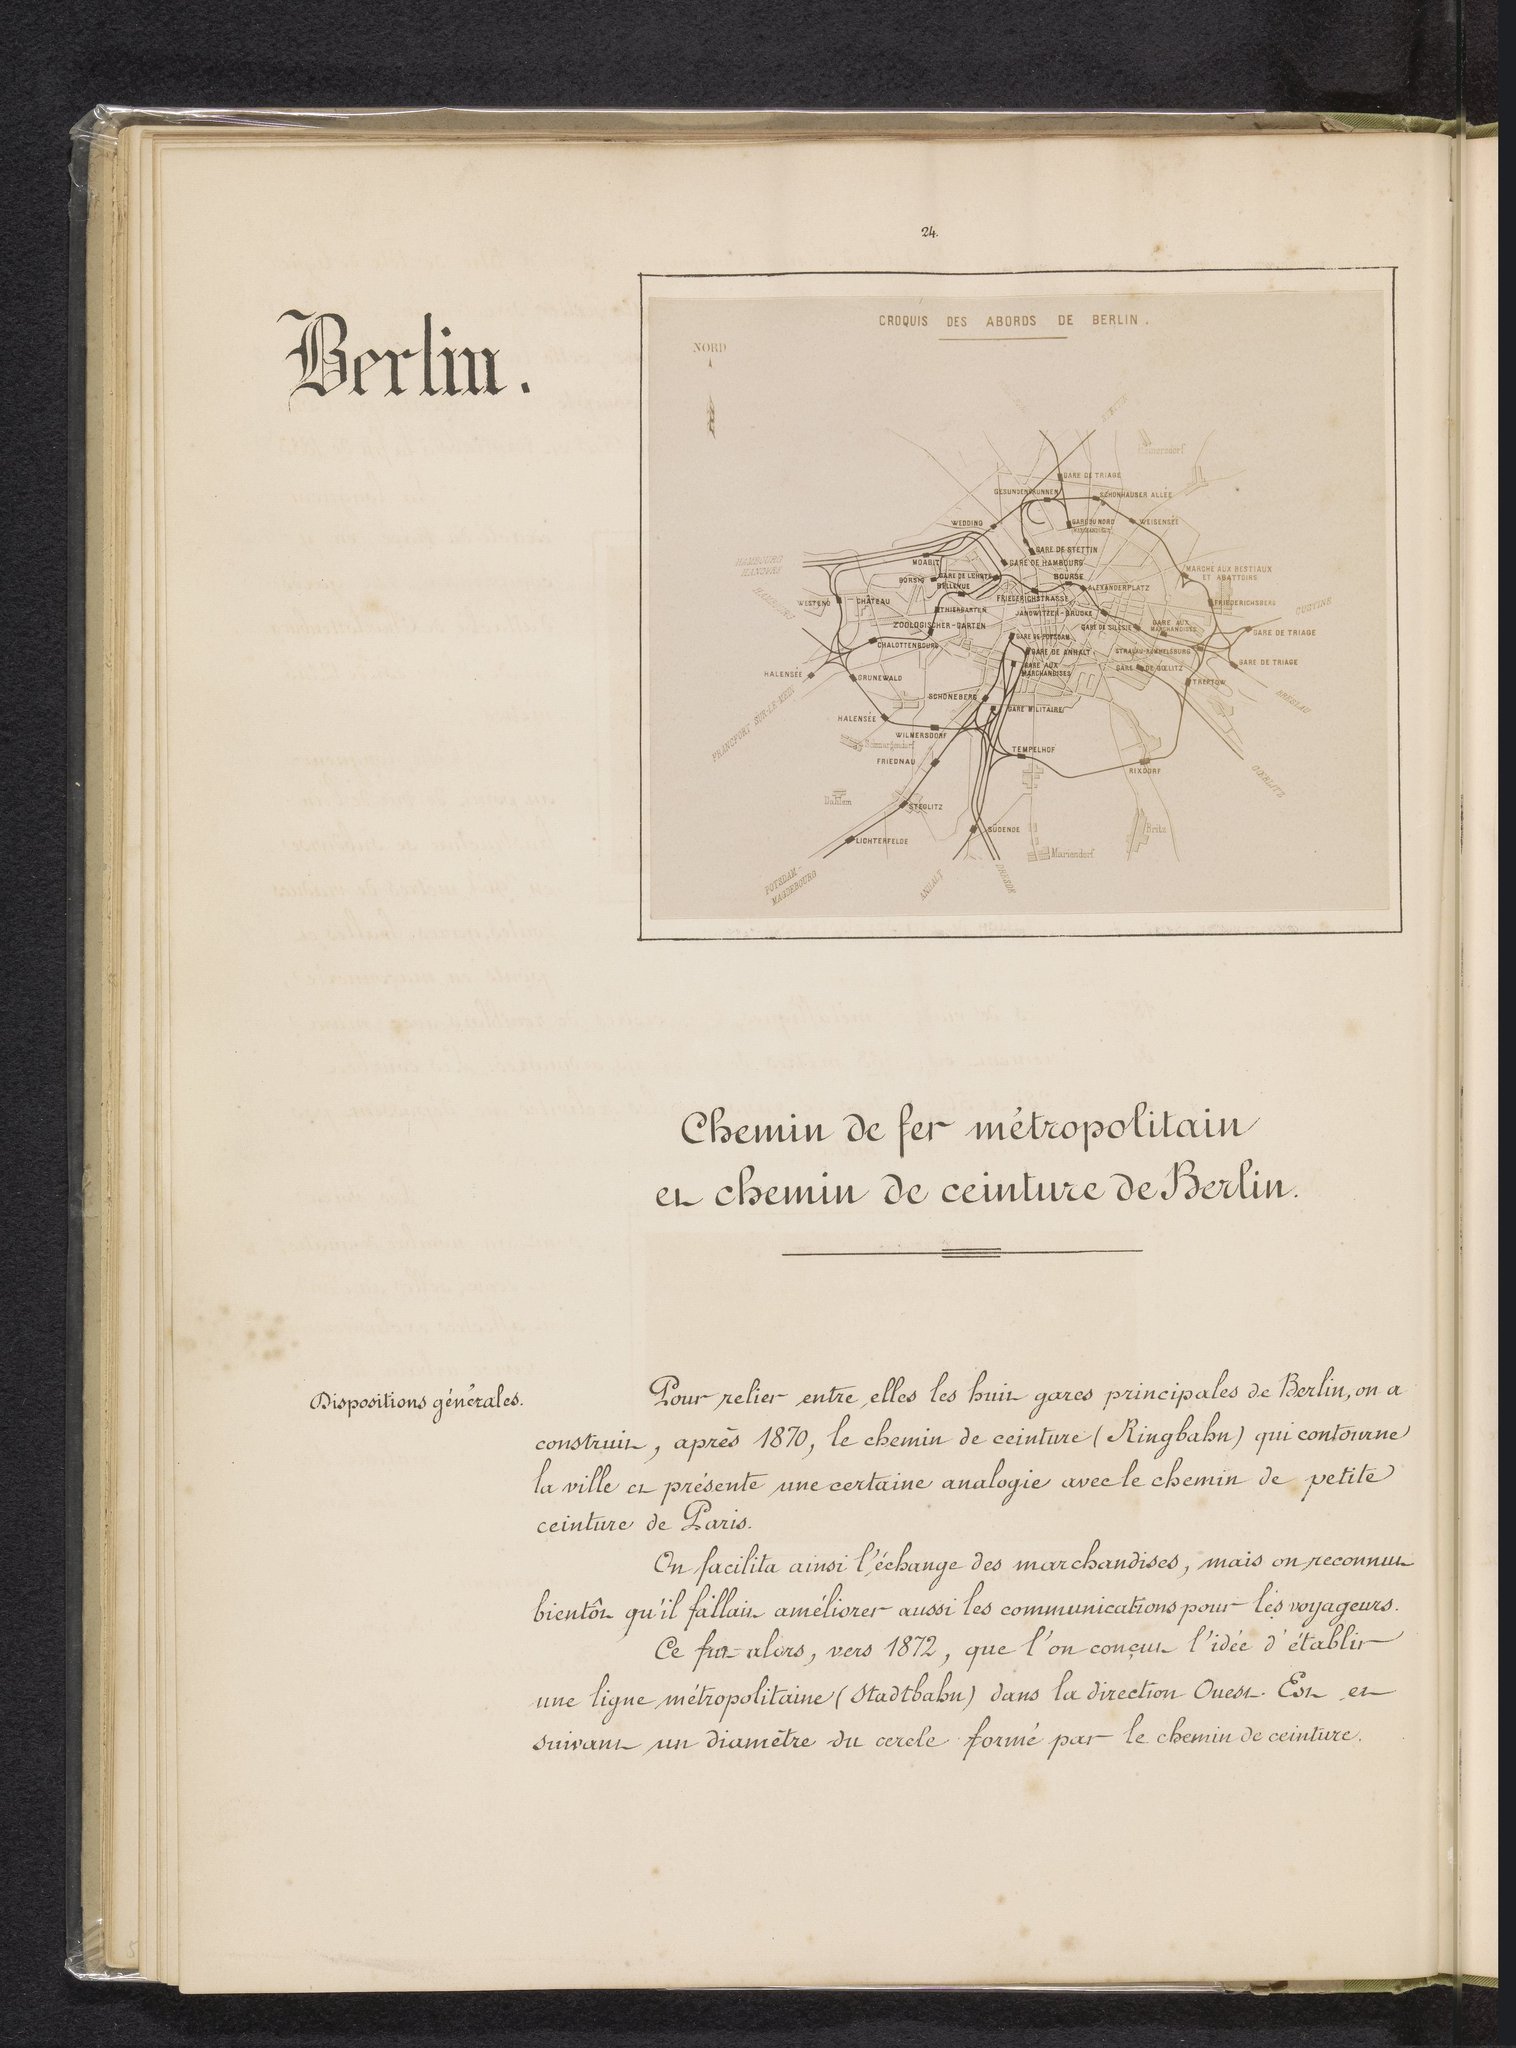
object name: page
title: Cruquis des abords de Berlin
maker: Anonymous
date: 1874-1884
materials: photographic support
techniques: albumen print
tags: maps, atlases, berlin